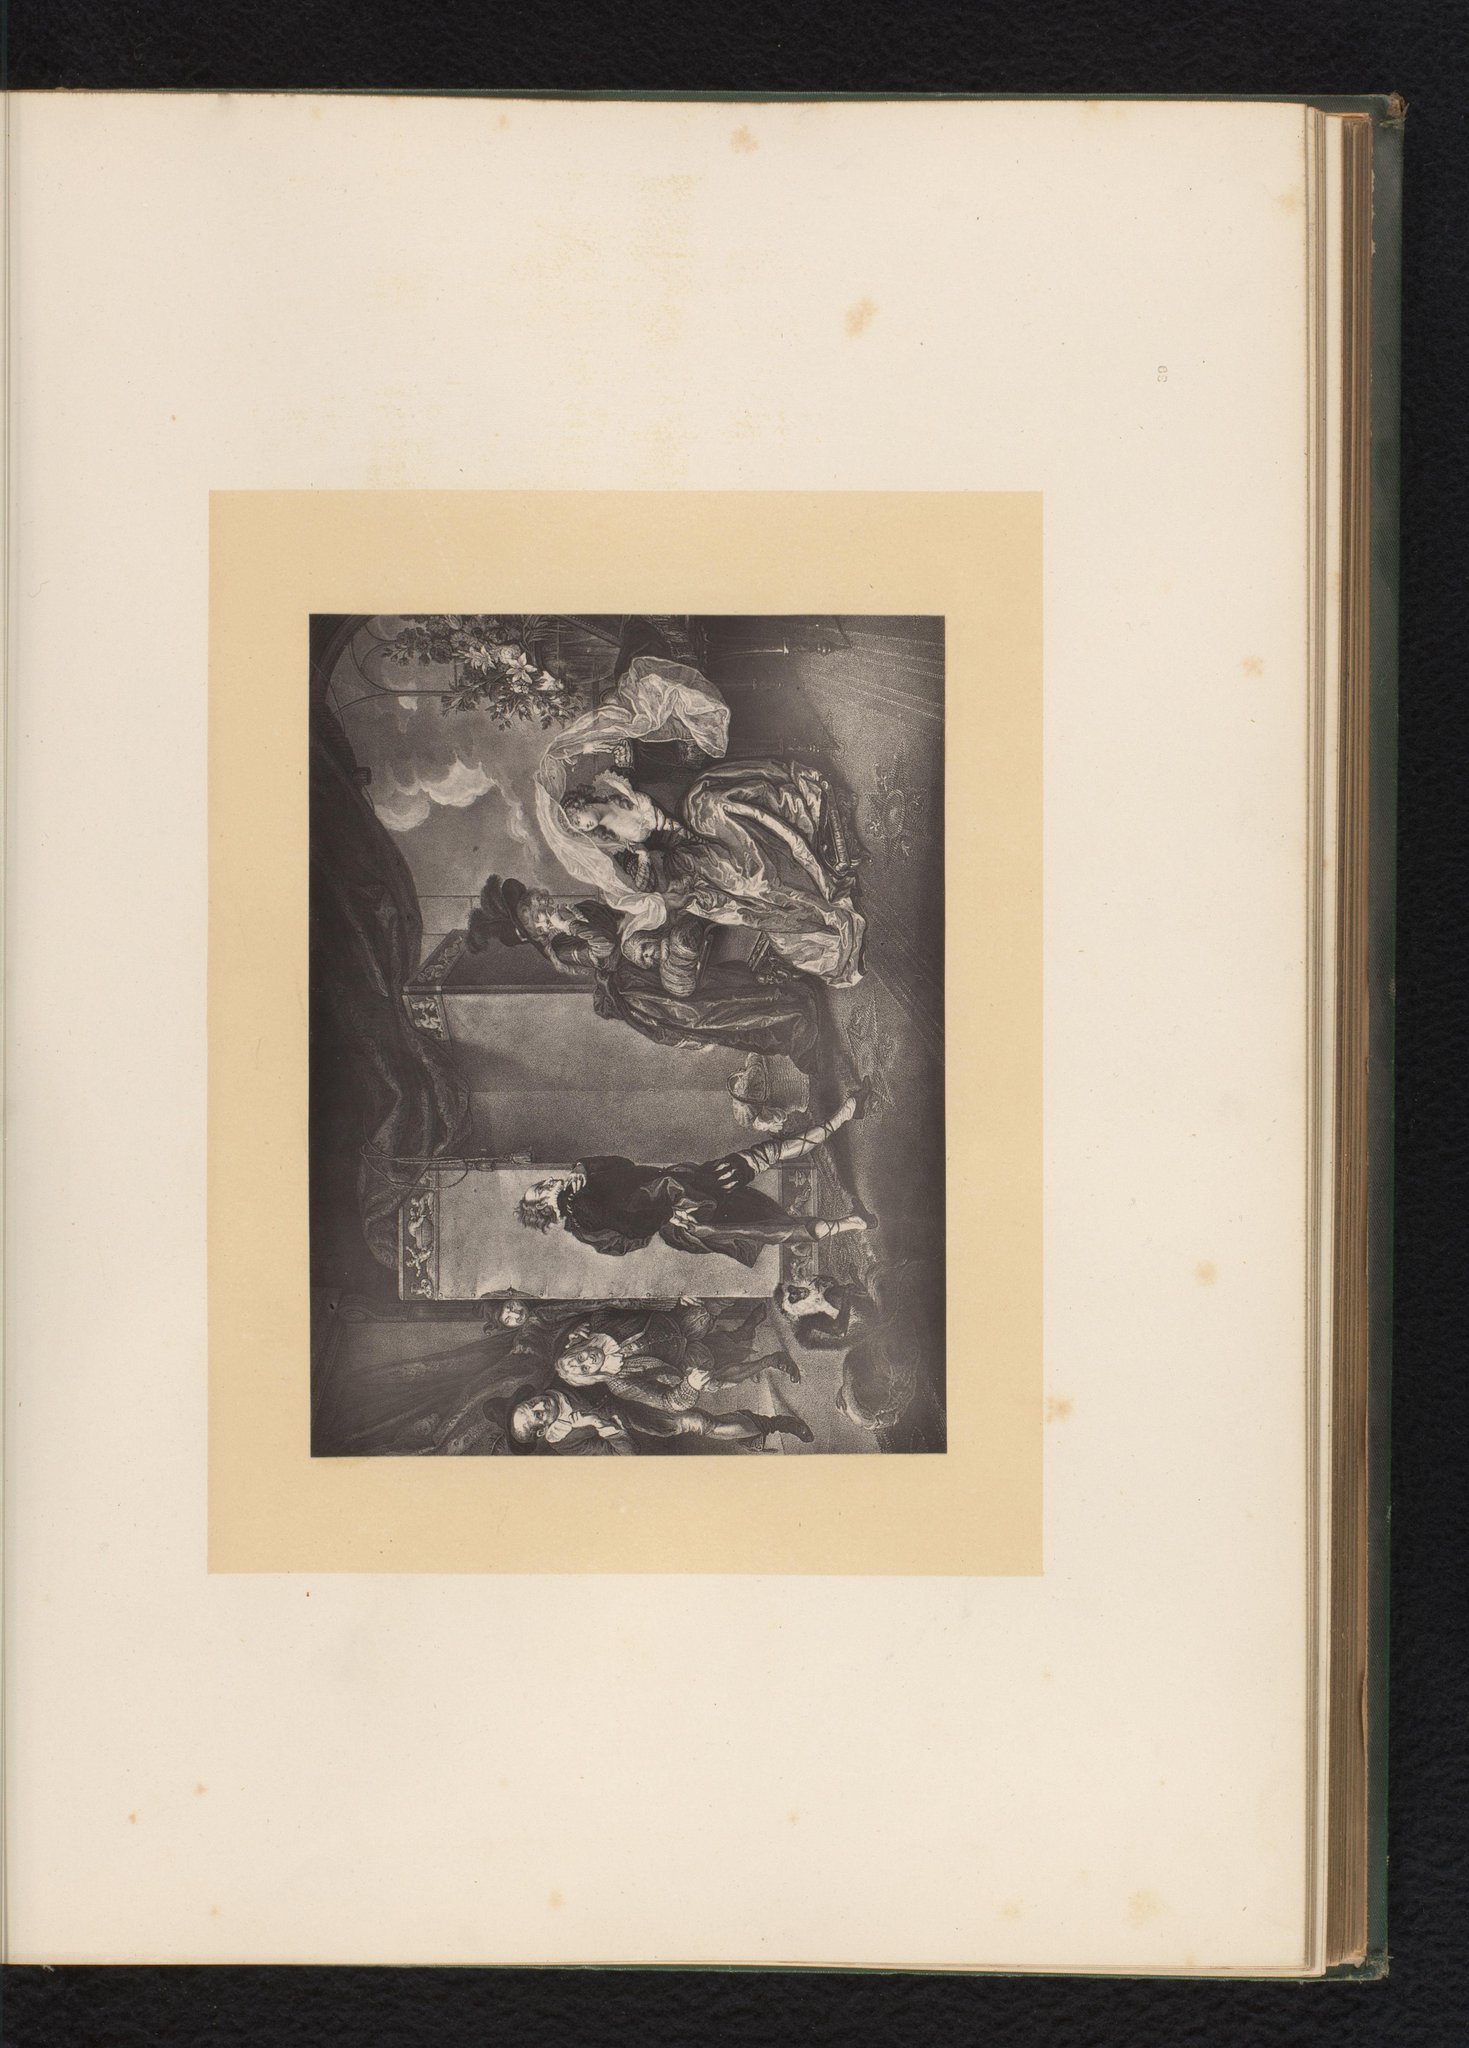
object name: reproduction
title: Twelfth Night, Act III, Scene 4: Olivia's House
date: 1874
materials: paper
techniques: woodburytype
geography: london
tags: comedy